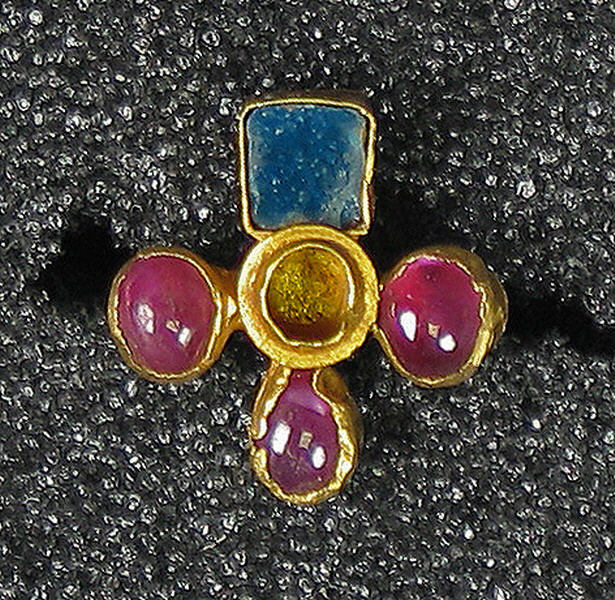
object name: earring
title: Earring, Quatreform with Rubies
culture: indonesian, central java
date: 701-1200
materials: gold